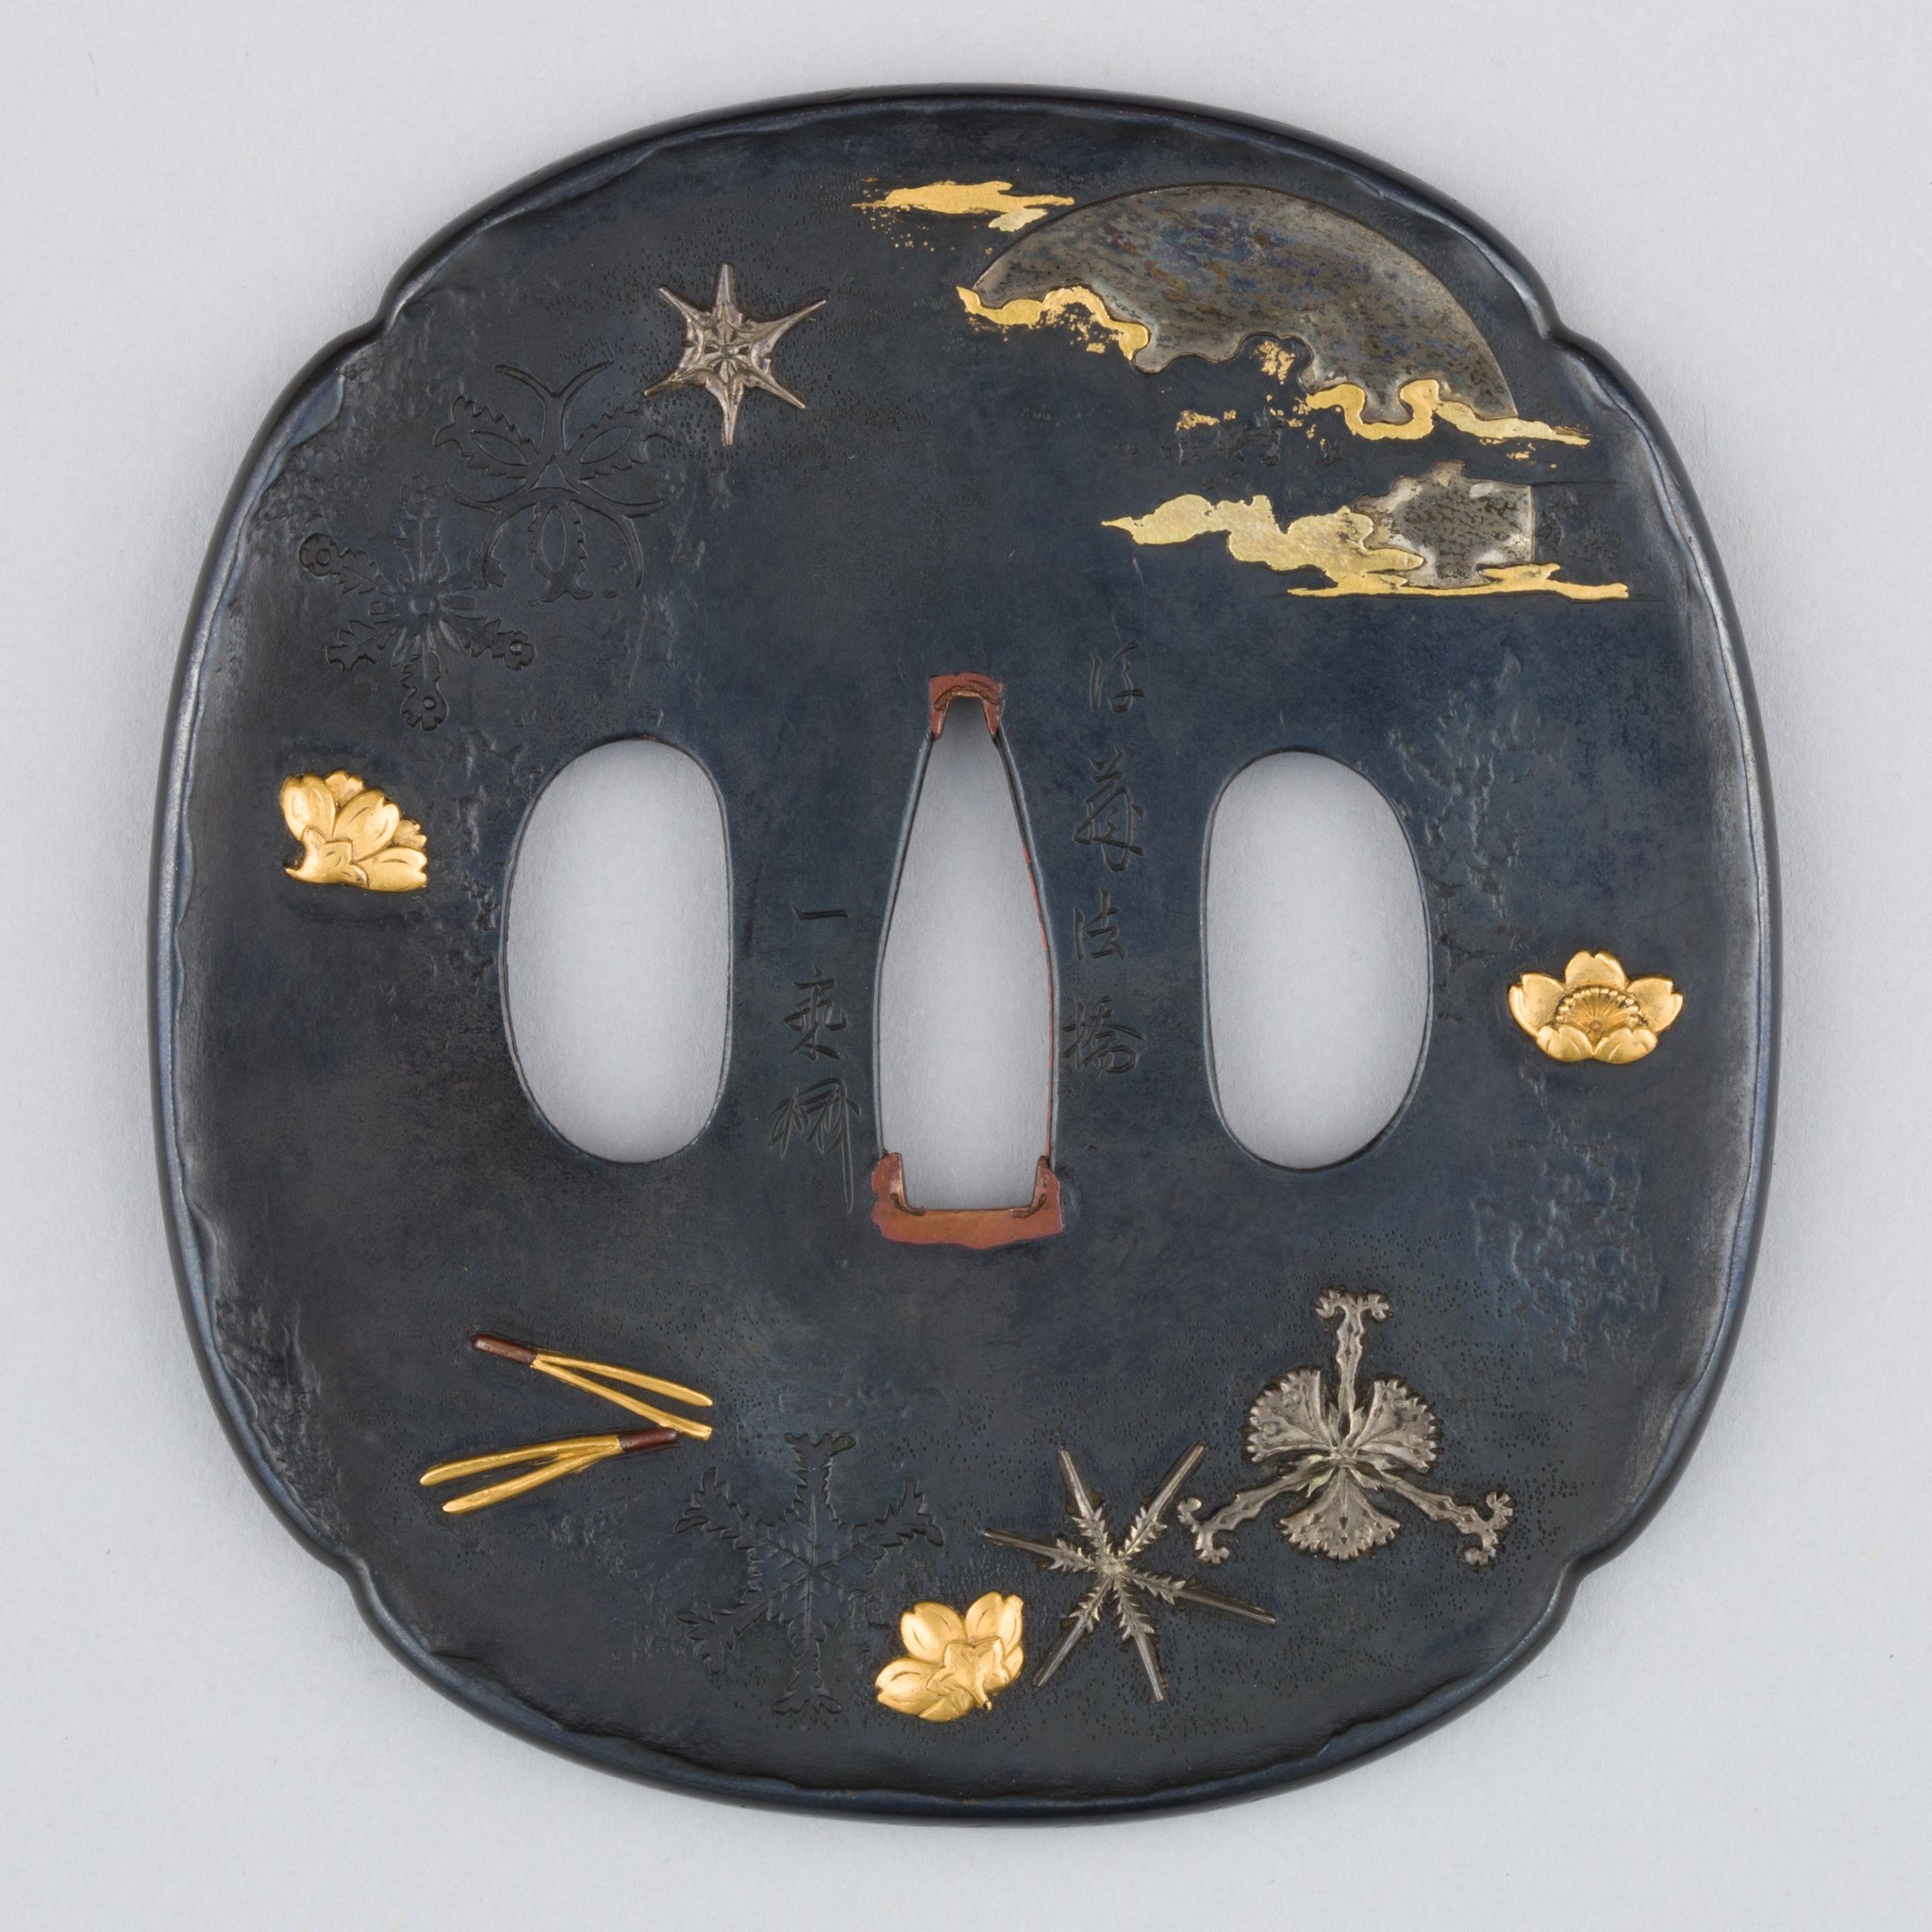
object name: sword guard tsuba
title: Sword Guard (Tsuba)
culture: japanese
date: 1801-1900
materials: copper, gold alloy, gold, silver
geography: japan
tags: flowers